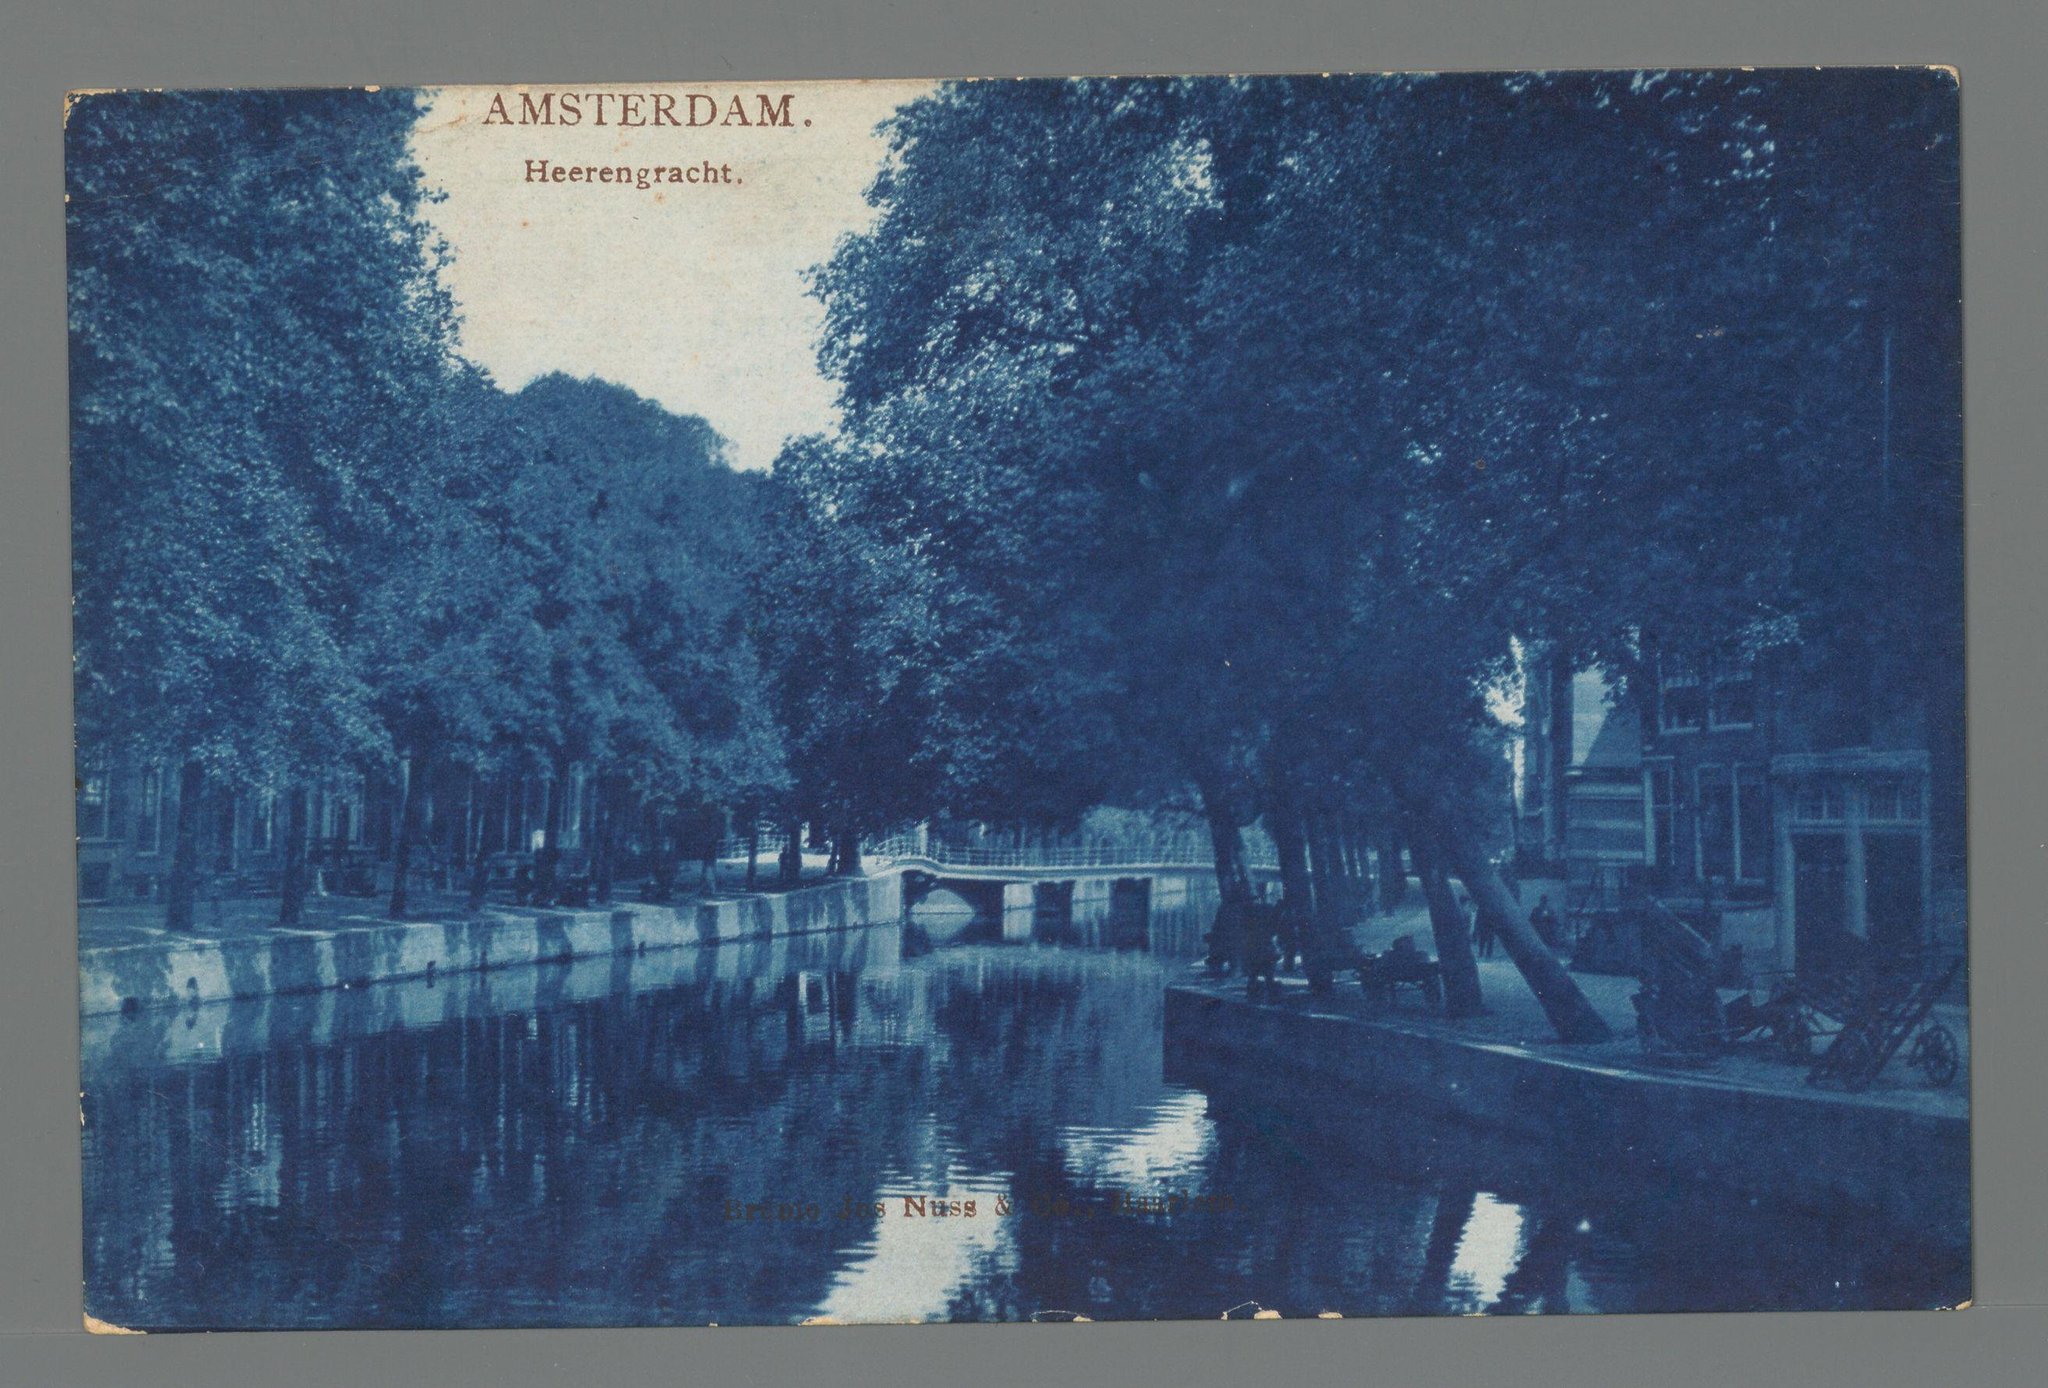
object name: ansichtkaart, prentbriefkaart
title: Amsterdam. Heerengracht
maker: Anonymous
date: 1906-1908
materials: cardboard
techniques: photograph, writing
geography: haarlem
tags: city-view, and landscape with man-made constructions, canals, waters (in city), bridge in city across river, canal, etc.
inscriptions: inscription: ‘G o G / Den Heer / Anne Plantinga / Wouterswoude’, postage stamp, inscription: ‘AMSTERDAM. / Heerengracht. / Bromo Jos Nuss & Co., Haarlem.’, inscription: ‘Drukwerk / BRIEFKAART POSTKARTE POSTCARD. / (CARTE POSTALE.) / FABRIEKSMERK [tulp in ruit] / [etc.]’